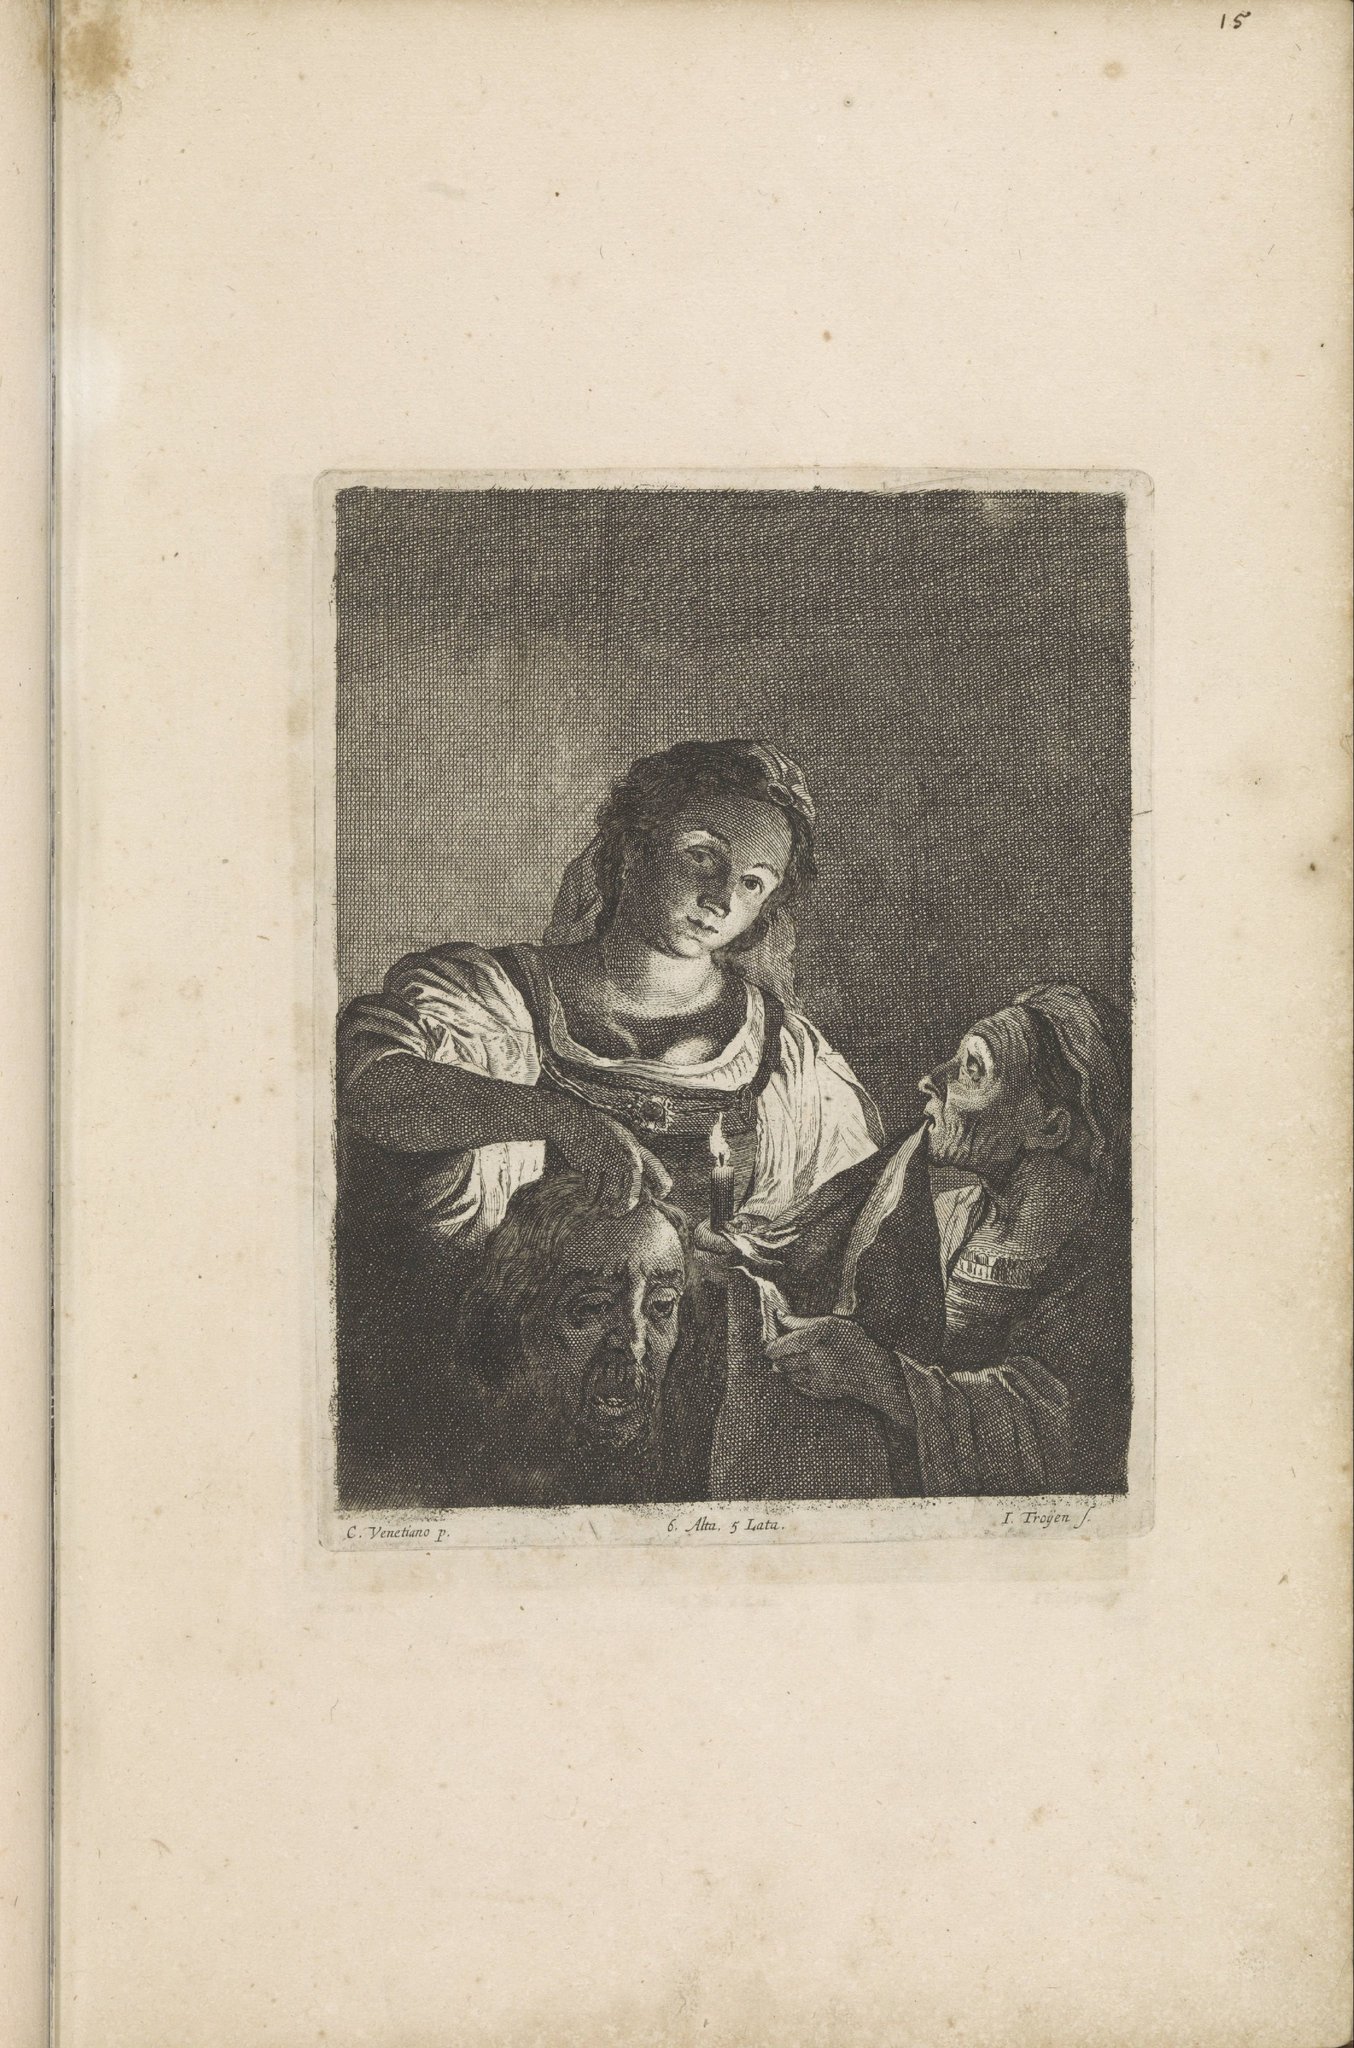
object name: print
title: Judit met het hoofd van Holofernes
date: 1660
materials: paper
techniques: engraving, etching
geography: southern netherlands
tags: judith and holofernes (judith 8-16)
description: Prent naar een schilderij van Saraceni dat zich in de collectie van het Kunsthistorisches Museum te Wenen bevindt (inventarisnummer: GG_41). David Teniers heeft waarschijnlijk van alle schilderijen uit de collectie van Leopold Willem van Oostenrijk een olieverfstudie op doek of paneel vervaardigd (zgn. pasticcio), die als voorbeeld voor de prentmakers diende. Het is niet altijd duidelijk of de pasticci door hem zijn gemaakt of door zijn atelier. Niet alle pasticci zijn overgeleverd.